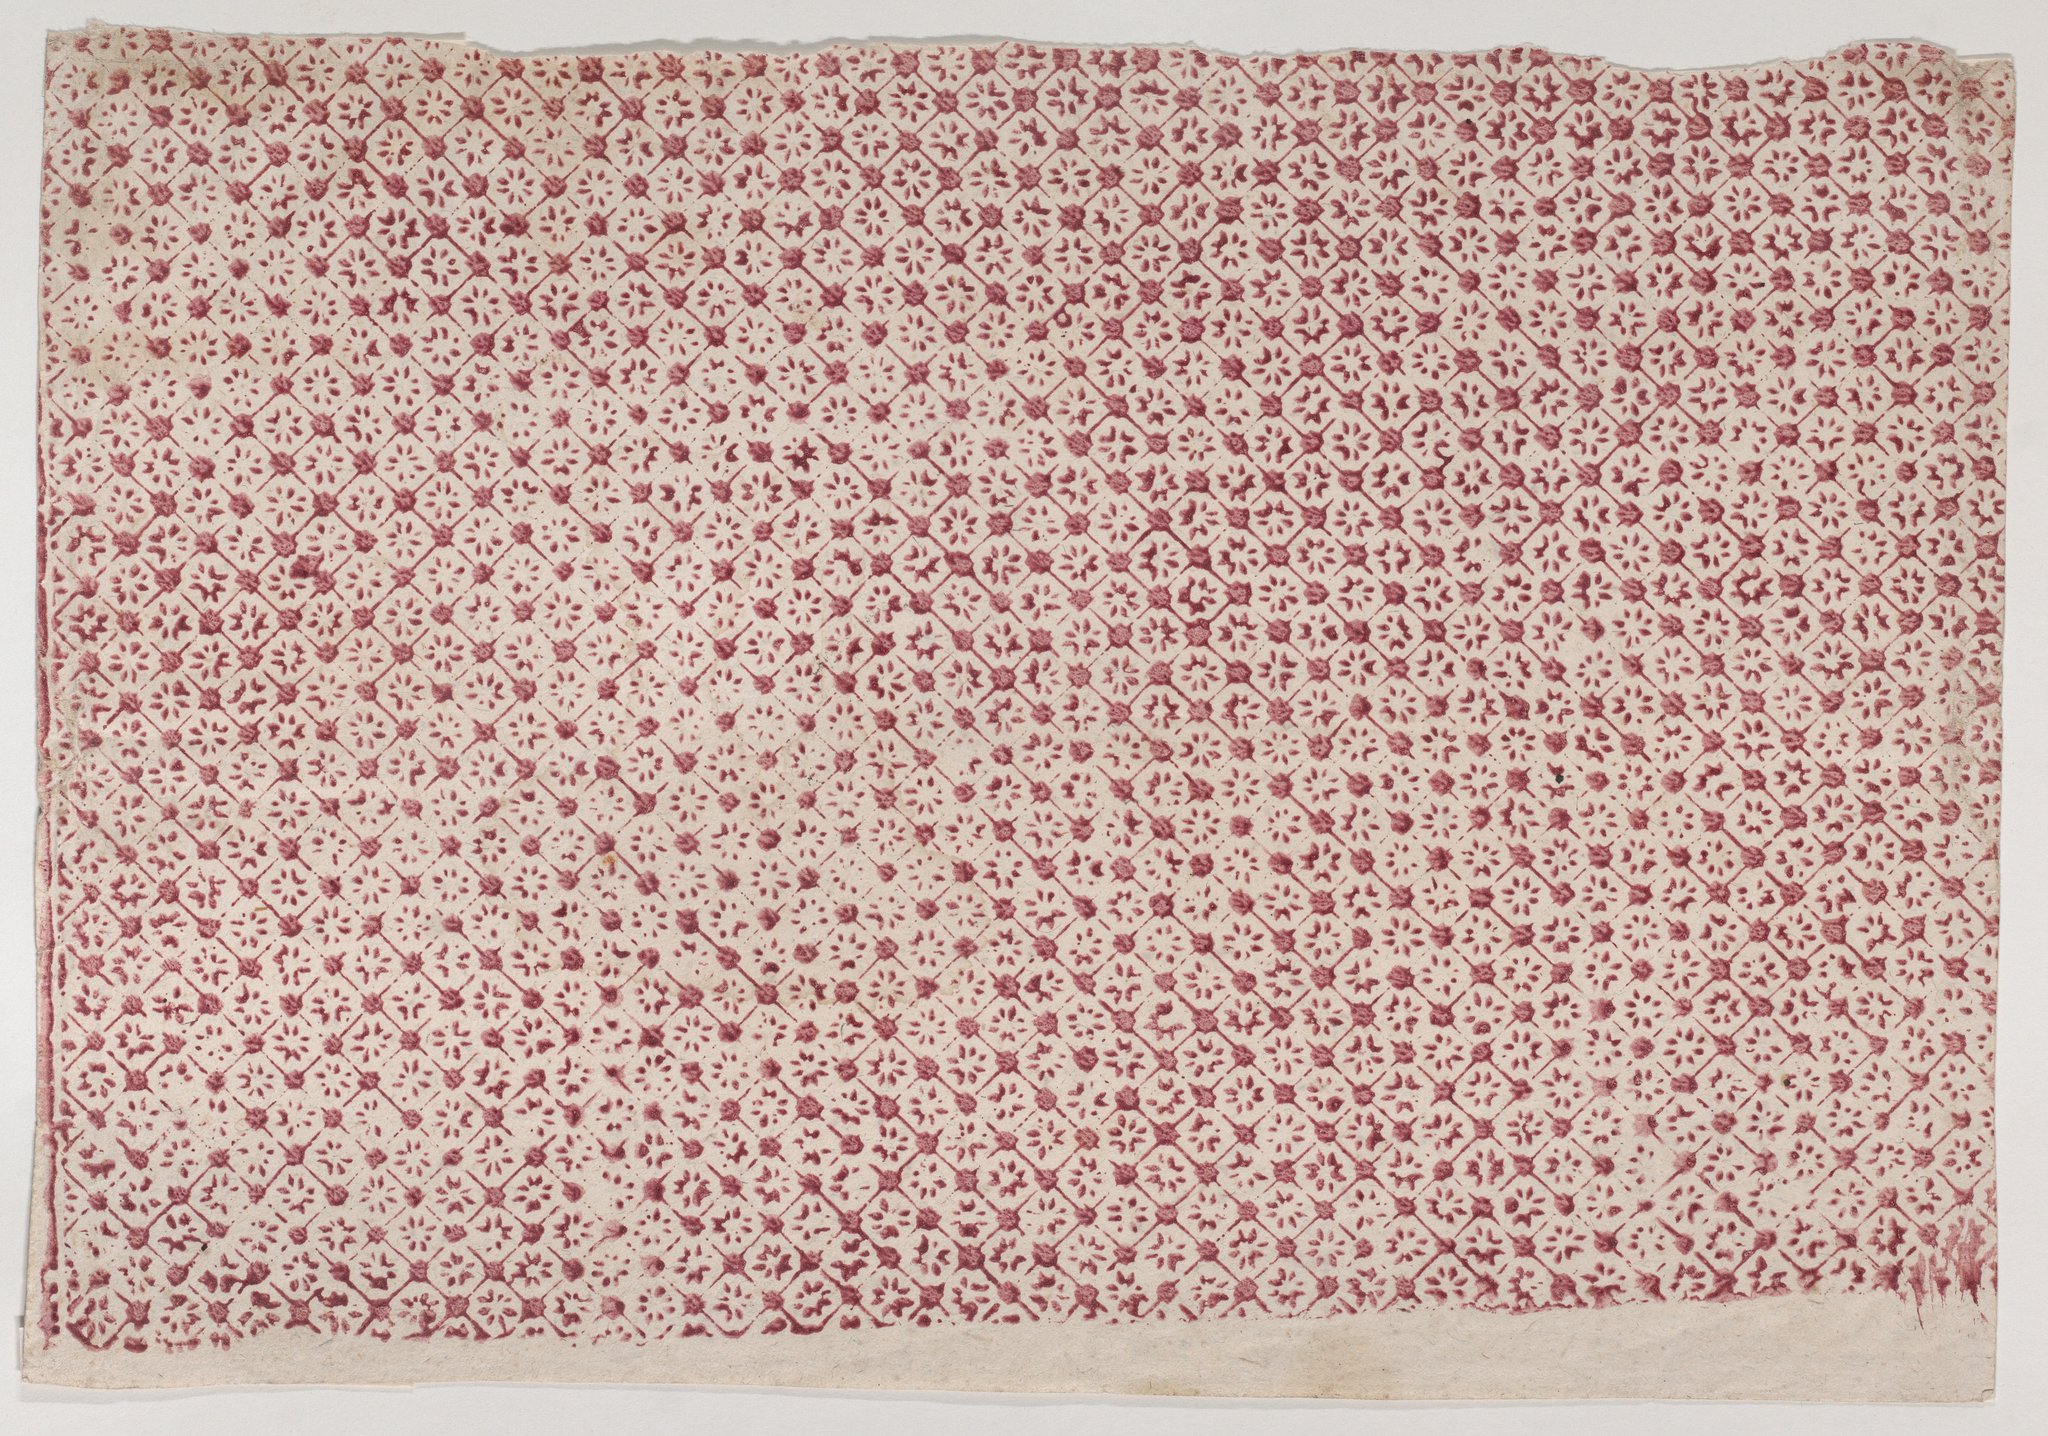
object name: print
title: Sheet with a red geometric and floral pattern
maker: Anonymous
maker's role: artist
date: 1801-1900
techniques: relief print